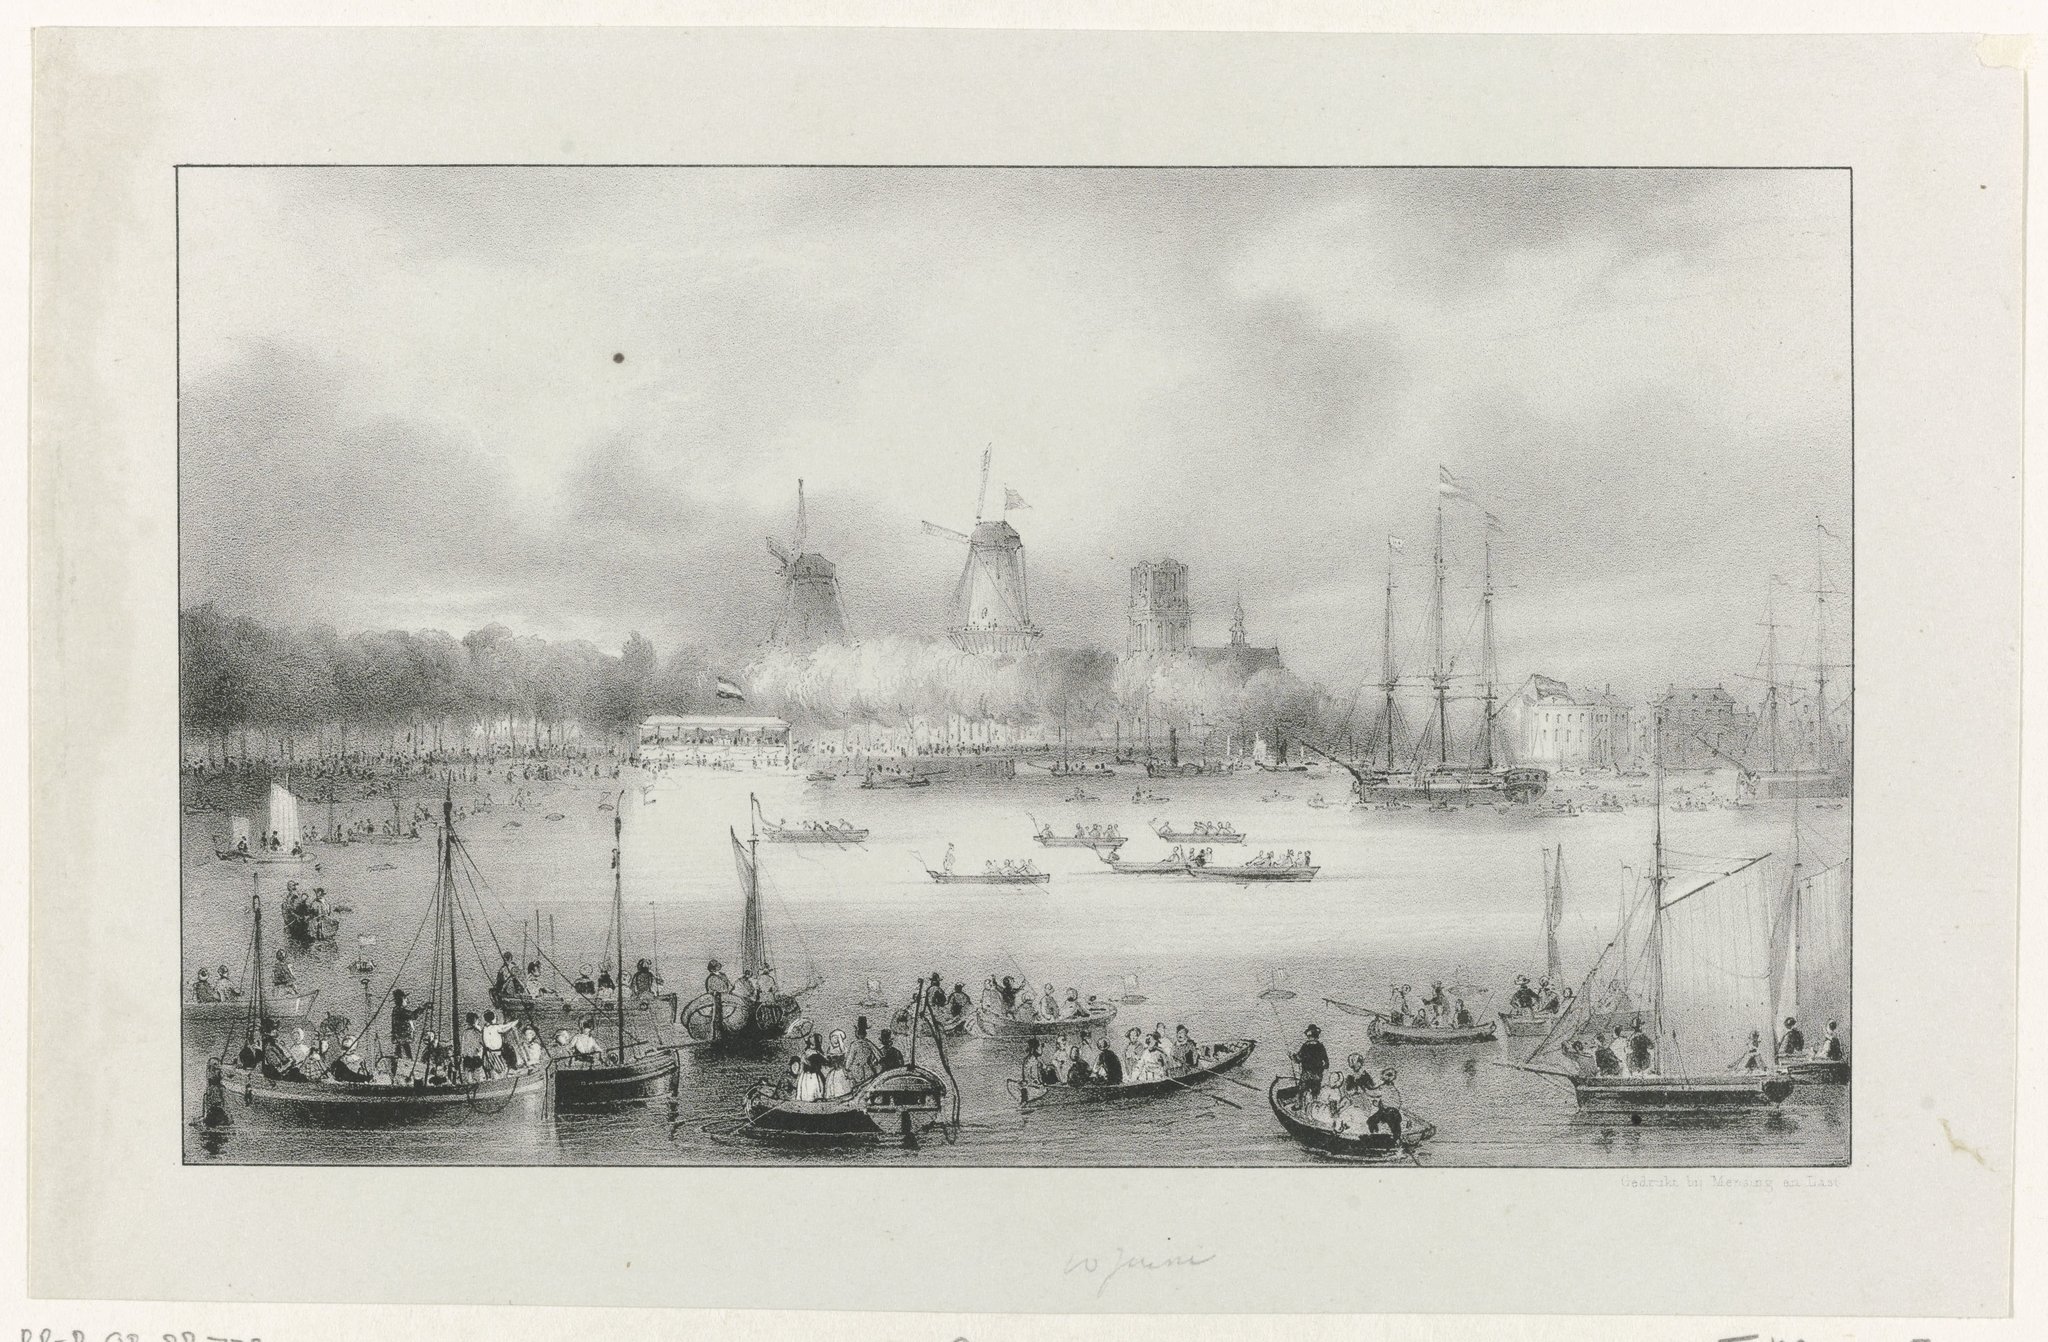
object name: print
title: De eerste roeiwedstrijd van de Koninklijke Nederlandsche Yachtclub, gehouden op 10 juni 1846 op de Maas te Rotterdam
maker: carel christiaan antony last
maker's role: print maker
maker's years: 1808-1876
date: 1846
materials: paper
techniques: lithograph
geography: netherlands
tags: rowing, canoeing, etc. (sport) (+ the contest (sports, games, etc.)), rotterdam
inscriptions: collector's mark: Lugt 2228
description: De eerste roeiwedstrijd van de Koninklijke Nederlandsche Yachtclub, gehouden op 10 juni 1846 op de Maas te Rotterdam. Gezicht op de Maas met centraal de deelnemende roeiboten. Op de voorgrond vele kleine bootjes met toeschouwers op het water. Aan de overzijde de publieke tribune.